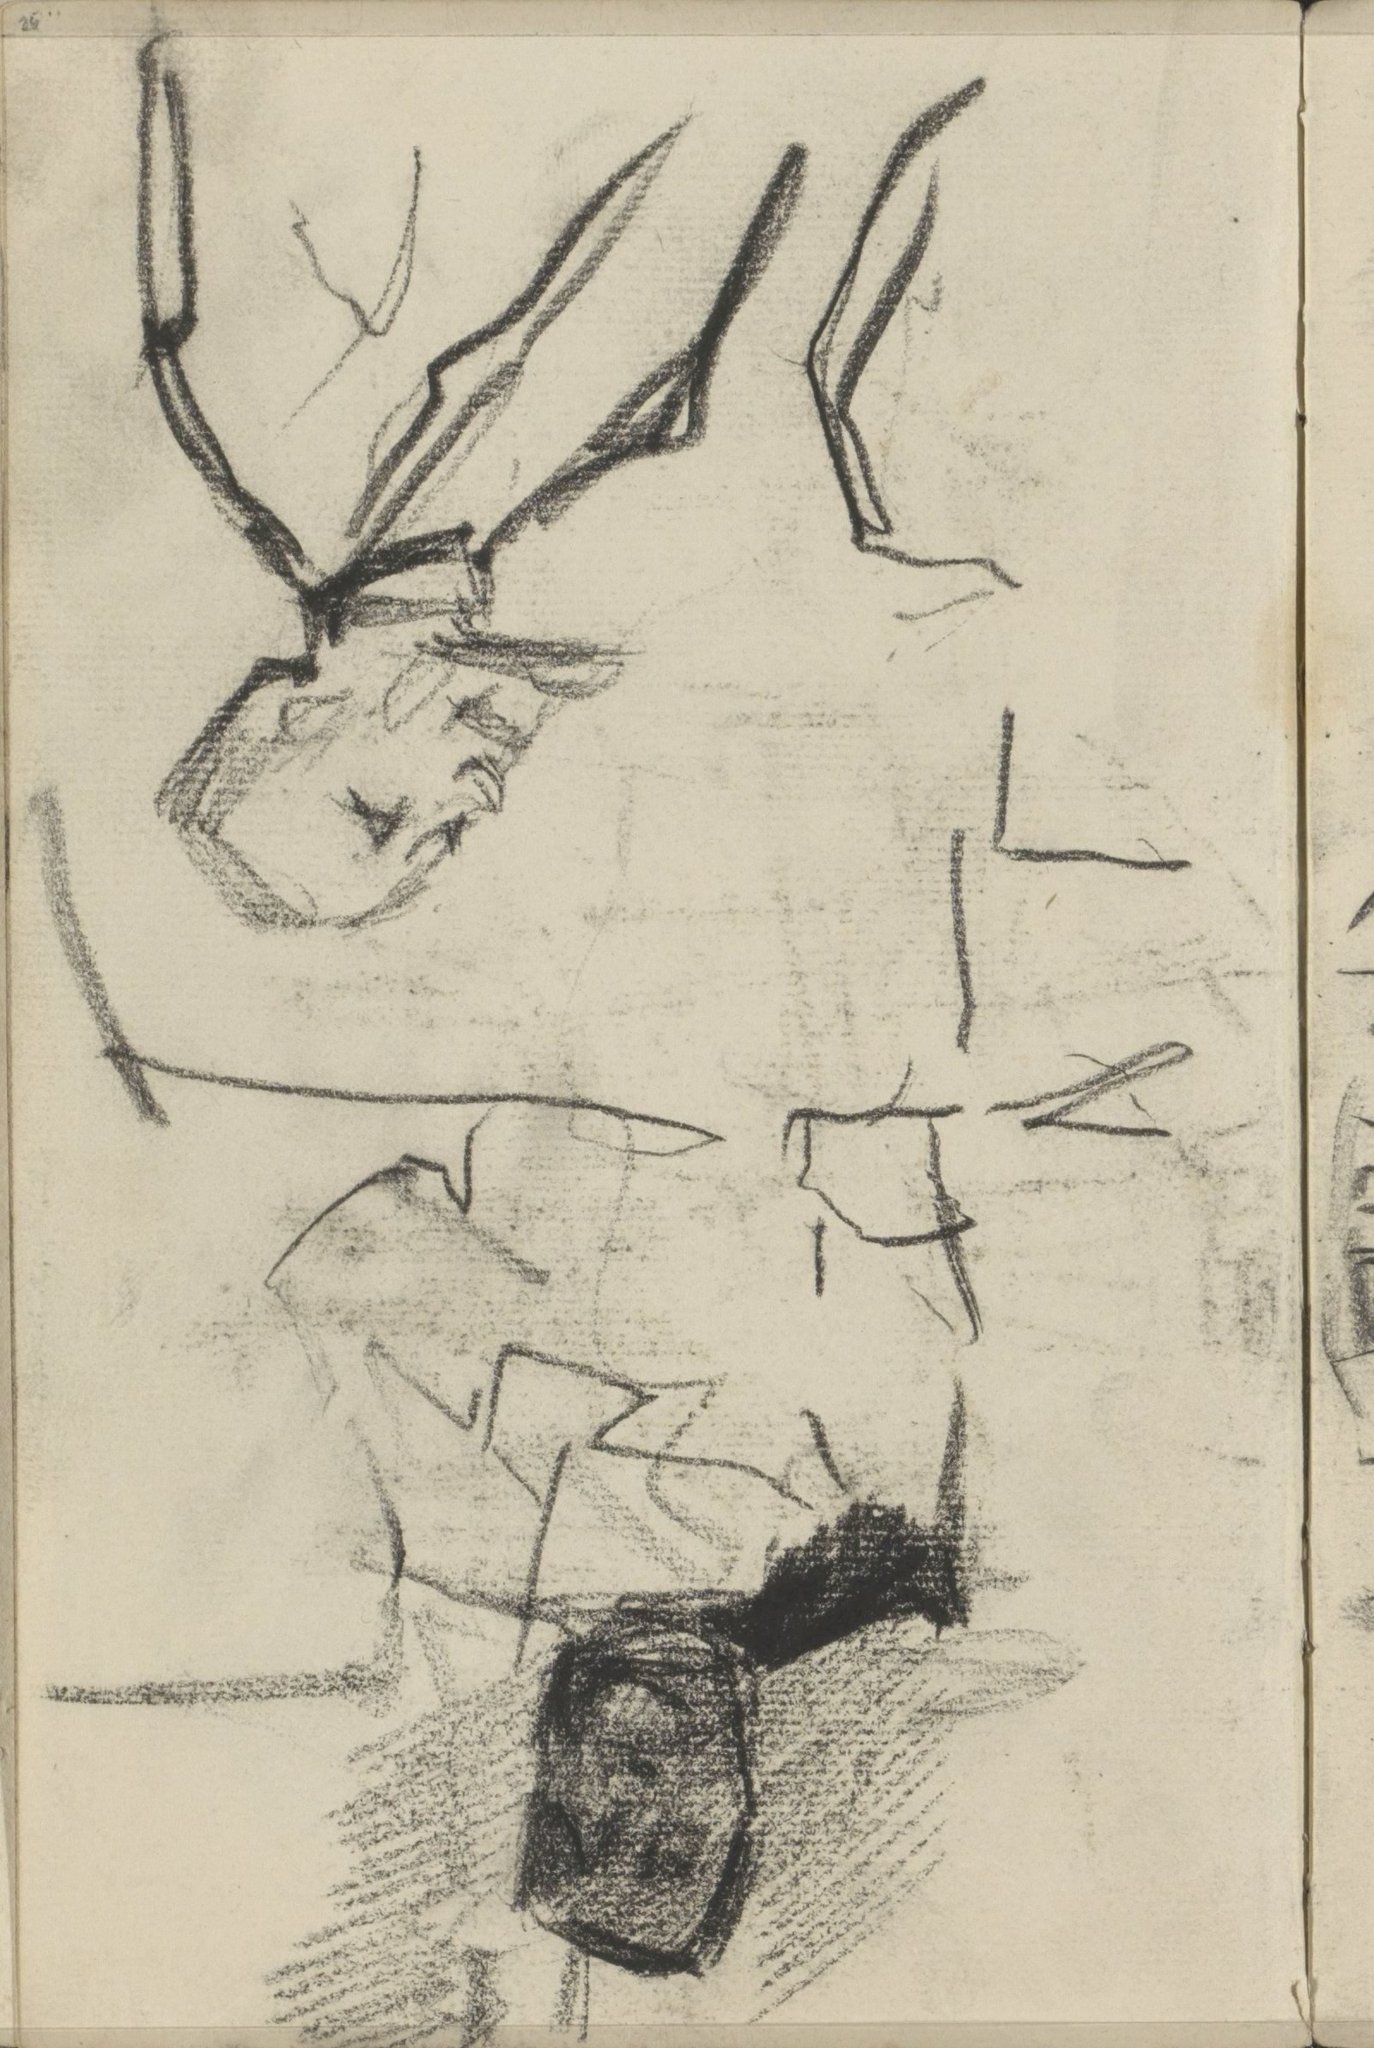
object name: sketchbook leaf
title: Twee mannen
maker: george hendrik breitner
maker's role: draughtsman, painter, print maker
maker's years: 1857-1923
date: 1886-1898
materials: chalk, paper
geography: amsterdam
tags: adult woman (+ two persons)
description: Pagina 25 uit een schetsboek met 18 bladen.